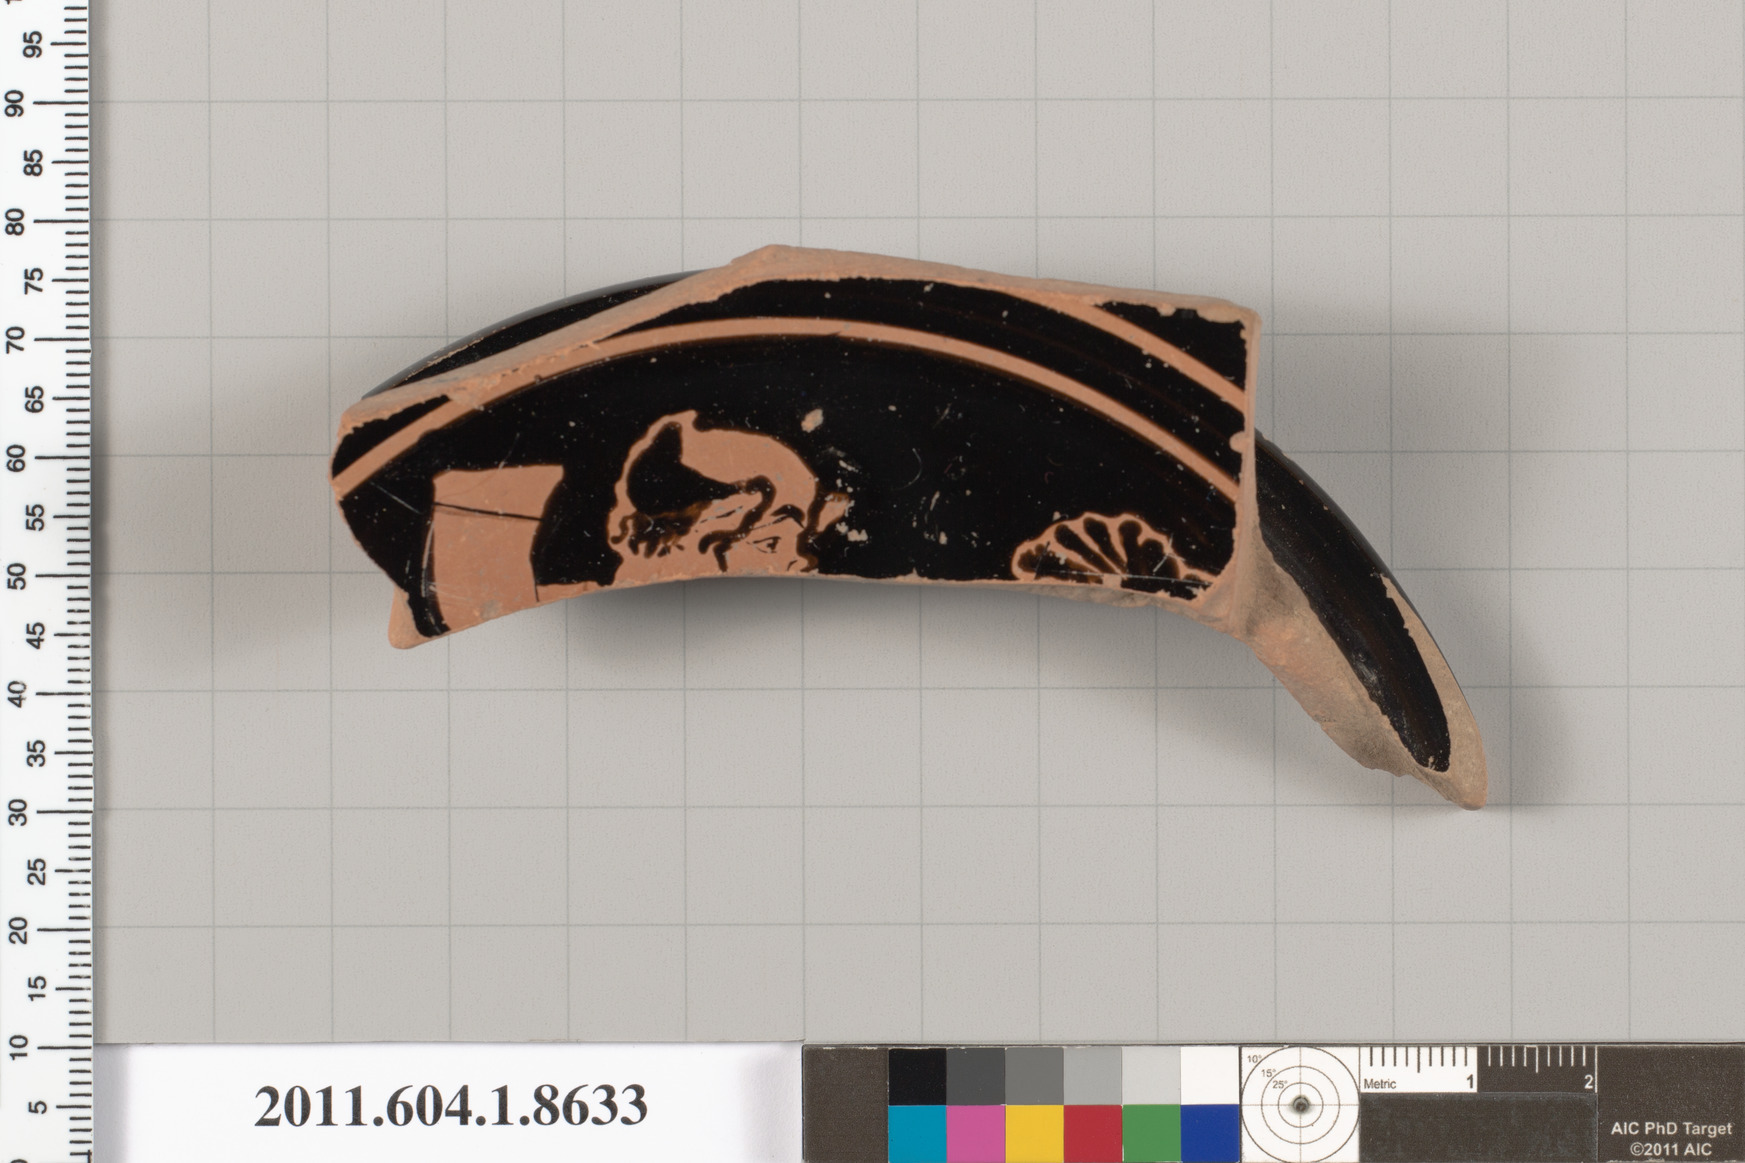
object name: kylix fragment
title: Terracotta fragment of a stemless kylix (drinking cup)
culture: greek, attic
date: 467-435 BCE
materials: terracotta